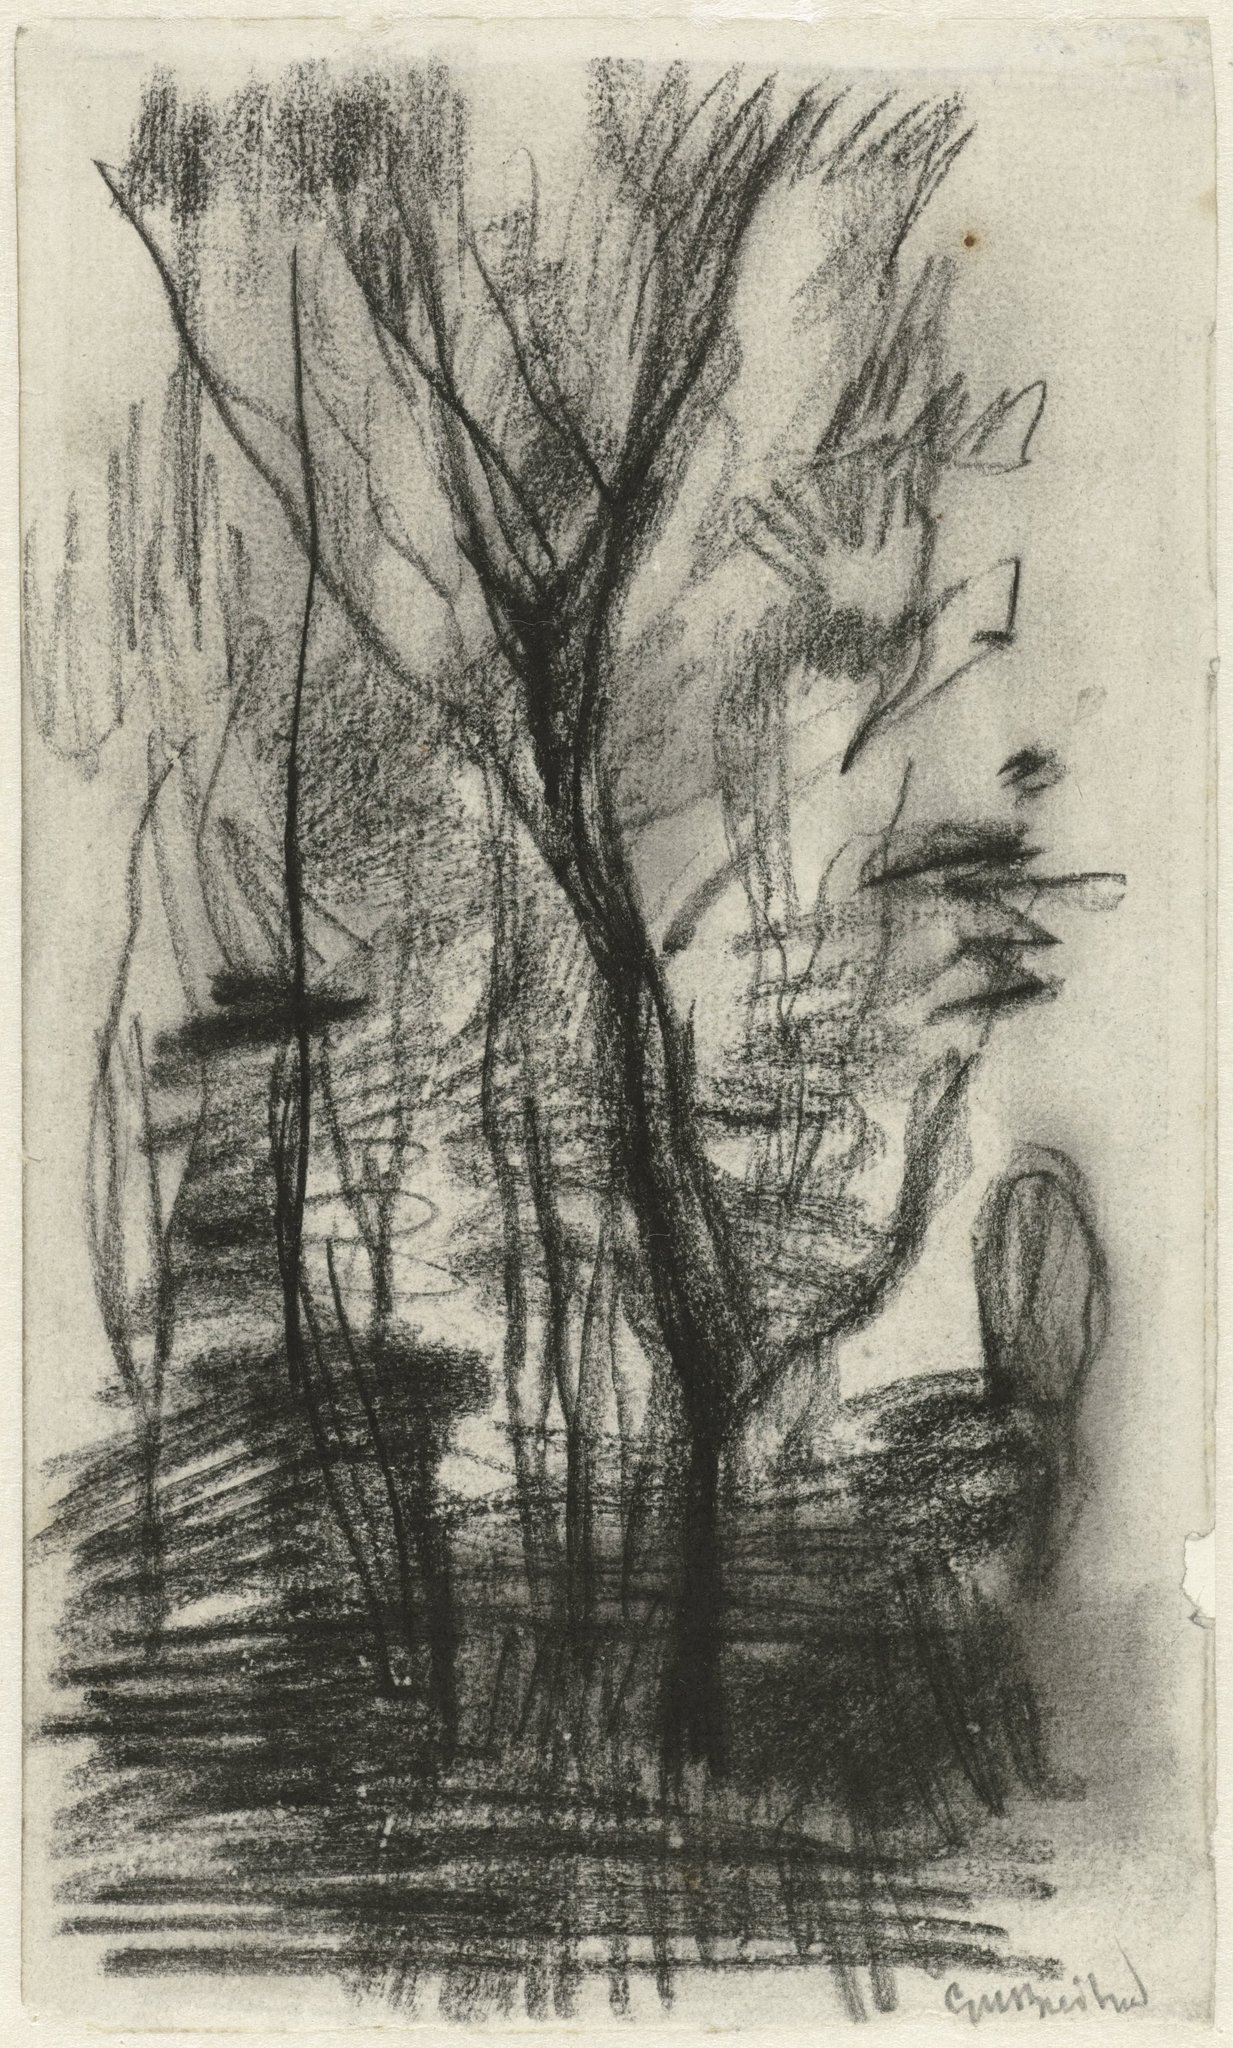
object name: drawing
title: Hoge bomen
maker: george hendrik breitner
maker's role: draughtsman, painter, print maker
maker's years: 1857-1923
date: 1867-1923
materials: chalk, paper